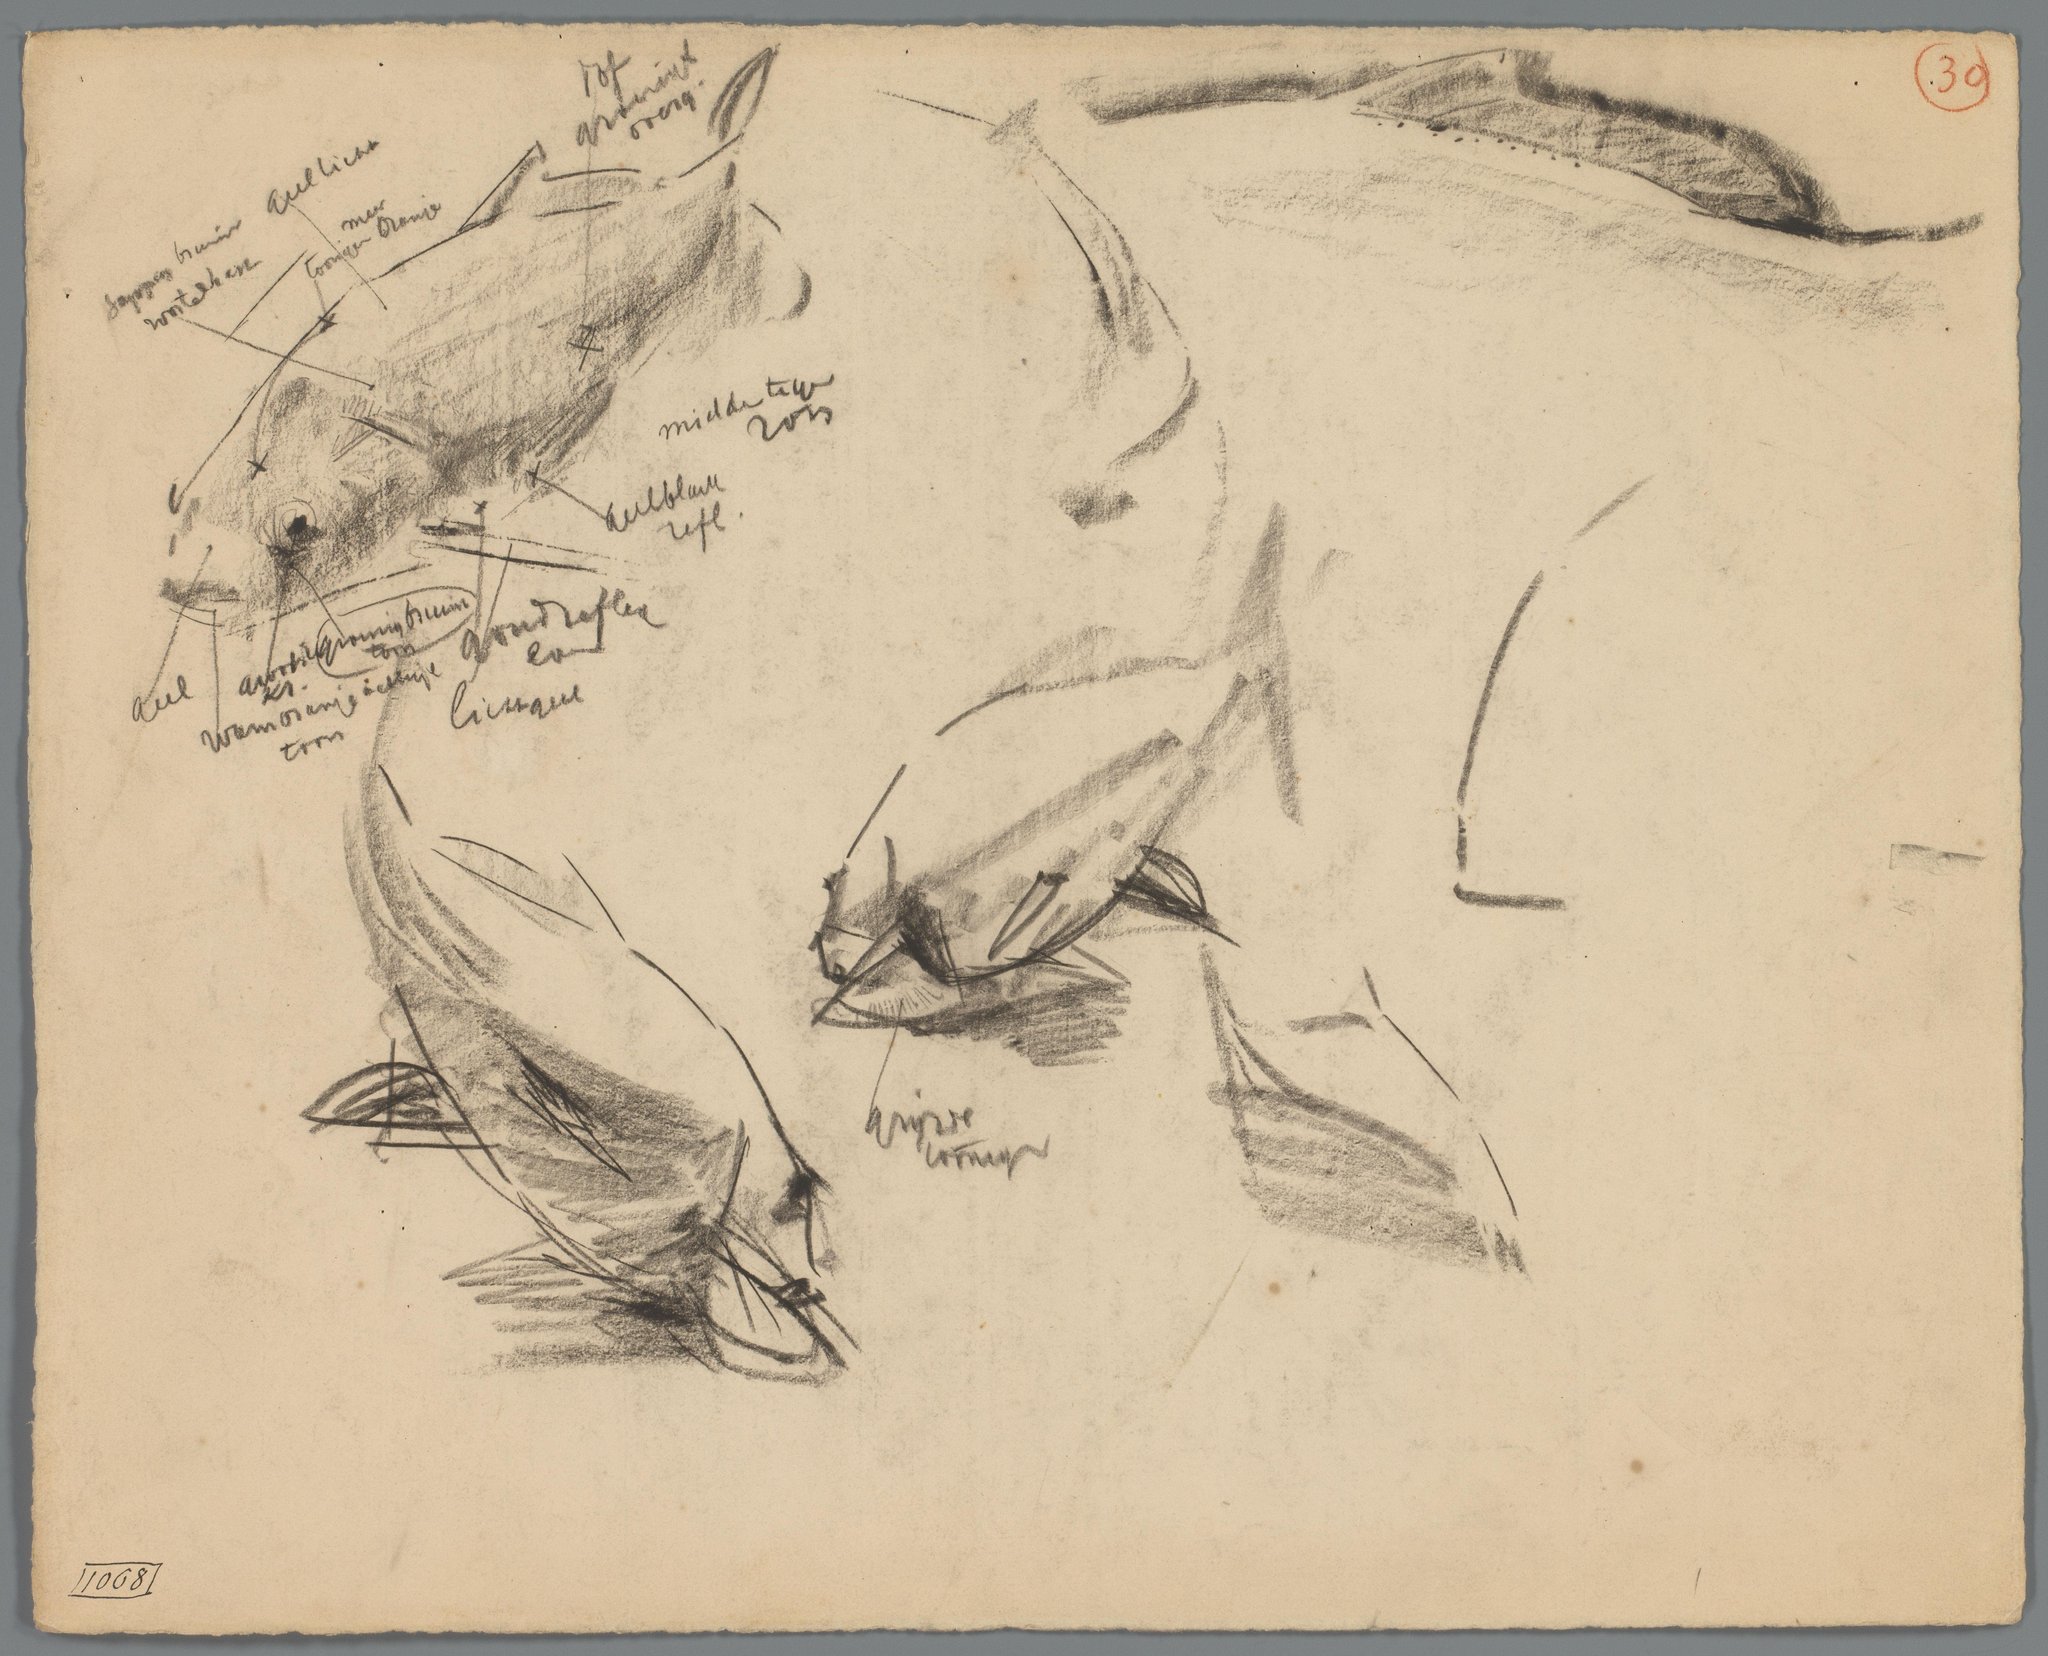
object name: drawing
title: Studies van karpers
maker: gerrit willem dijsselhof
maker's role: designer, draughtsman, print maker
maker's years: 1866-1924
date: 1876-1924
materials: chalk, paper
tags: bony fishes: carp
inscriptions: number: ‘1068’